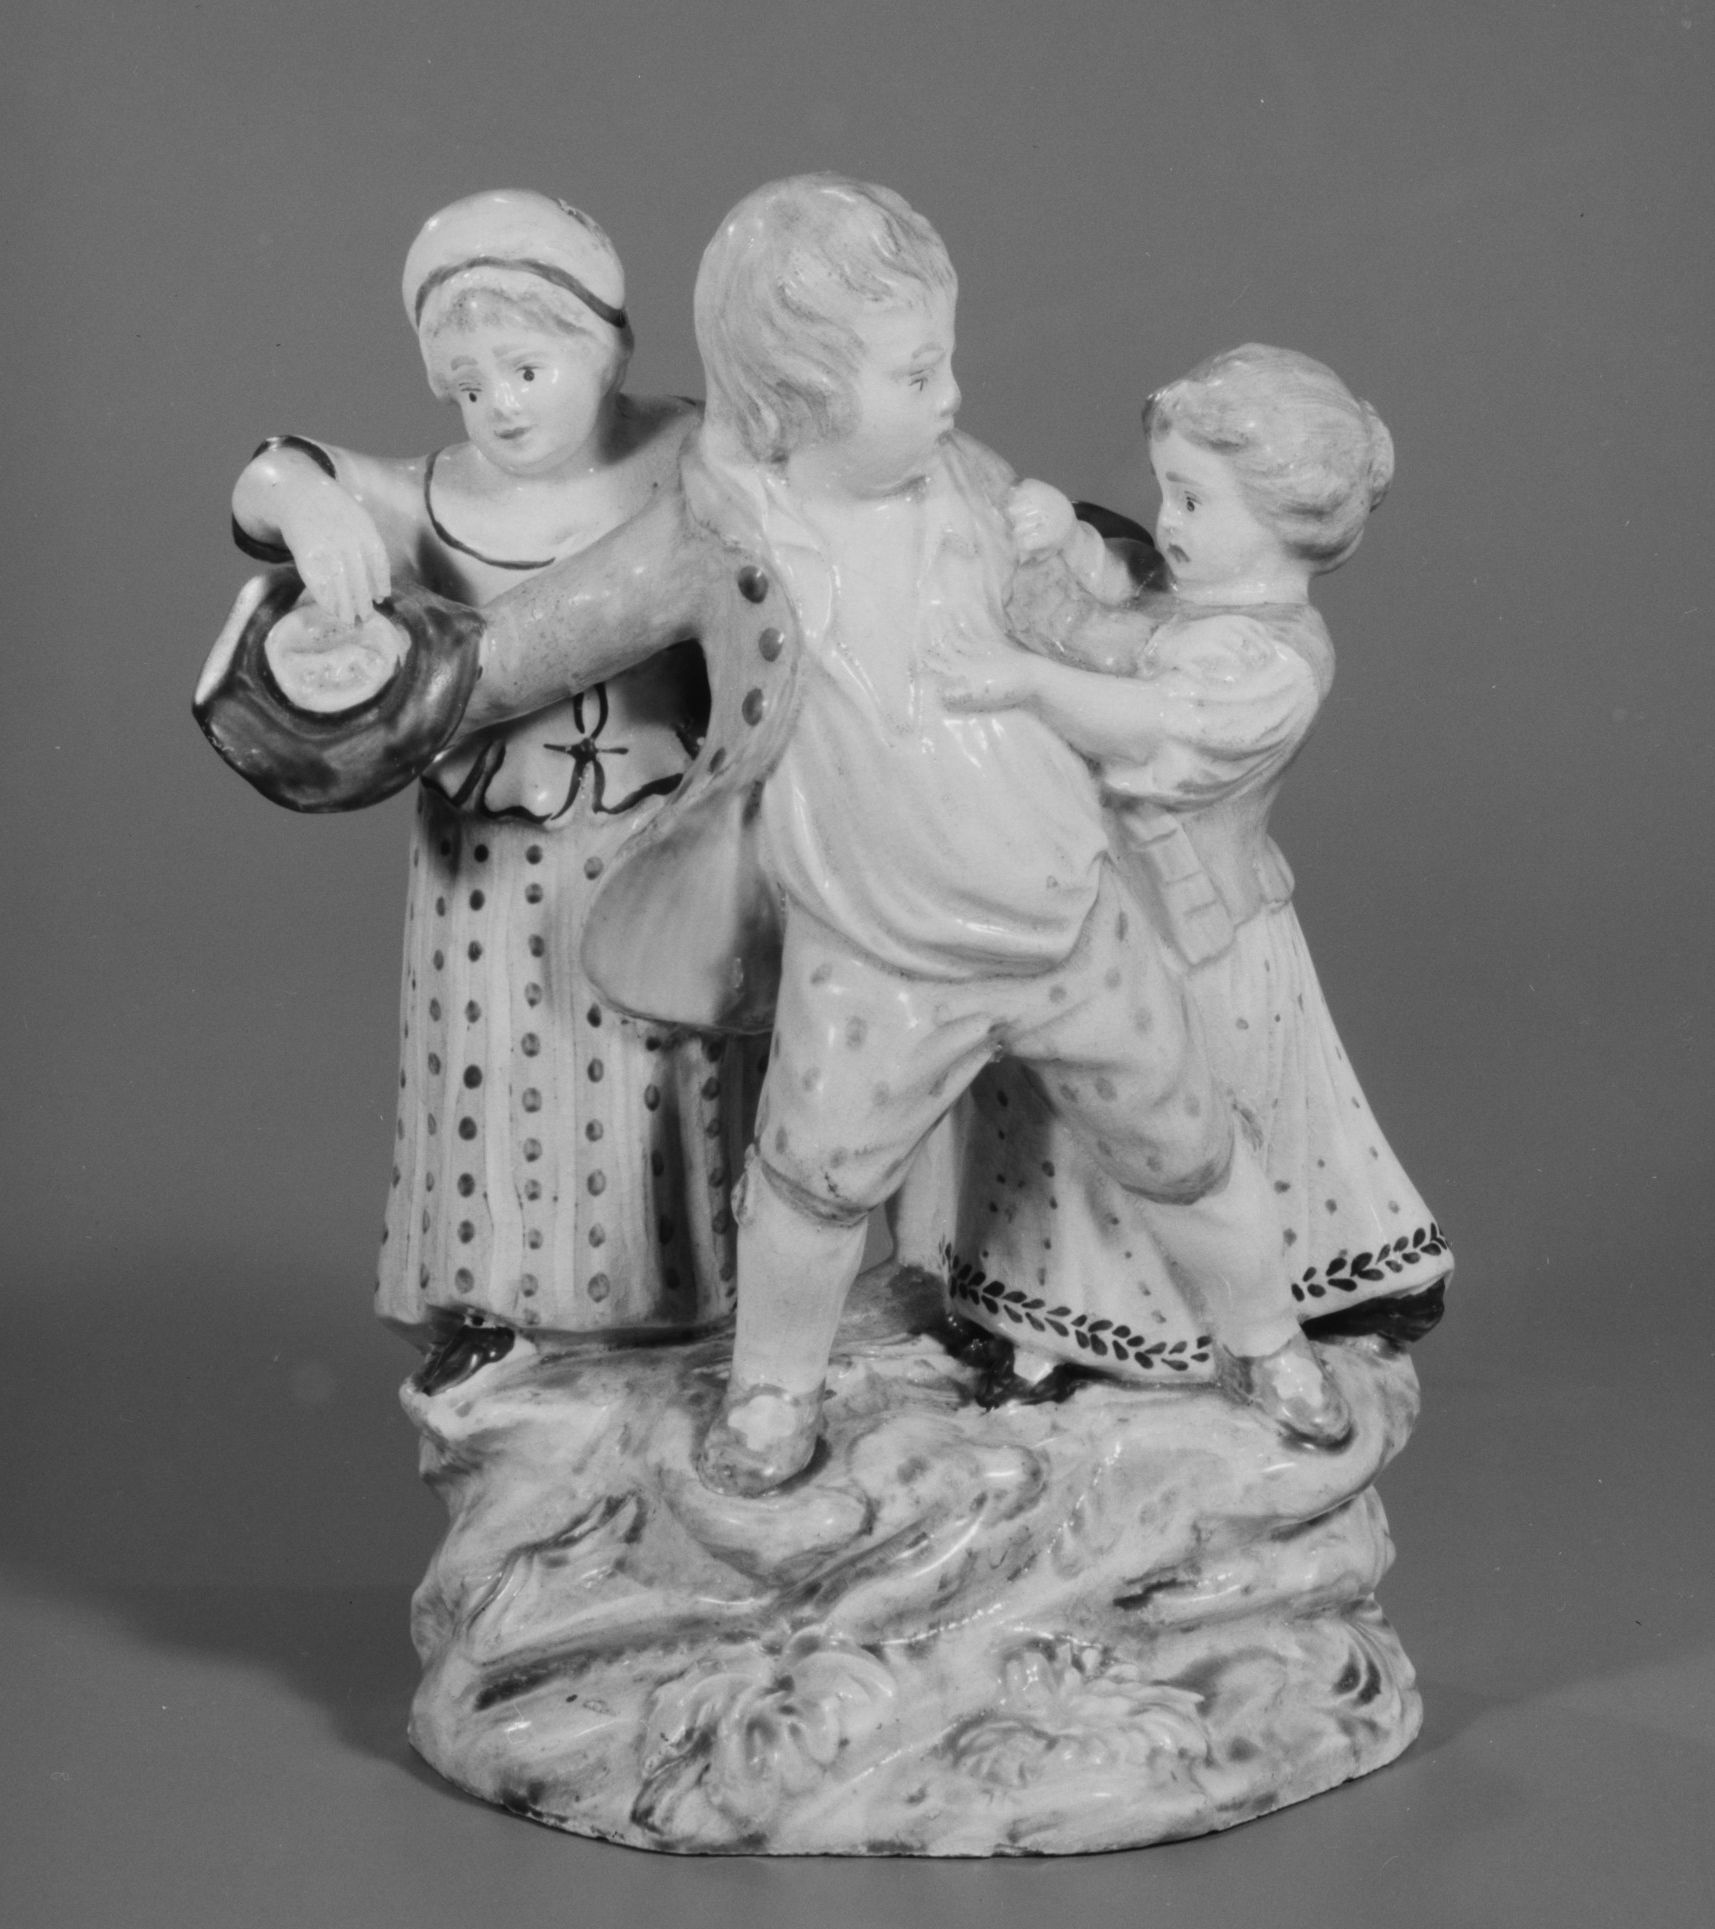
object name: figure group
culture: british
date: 1785-1835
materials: earthenware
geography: england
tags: boys,girls